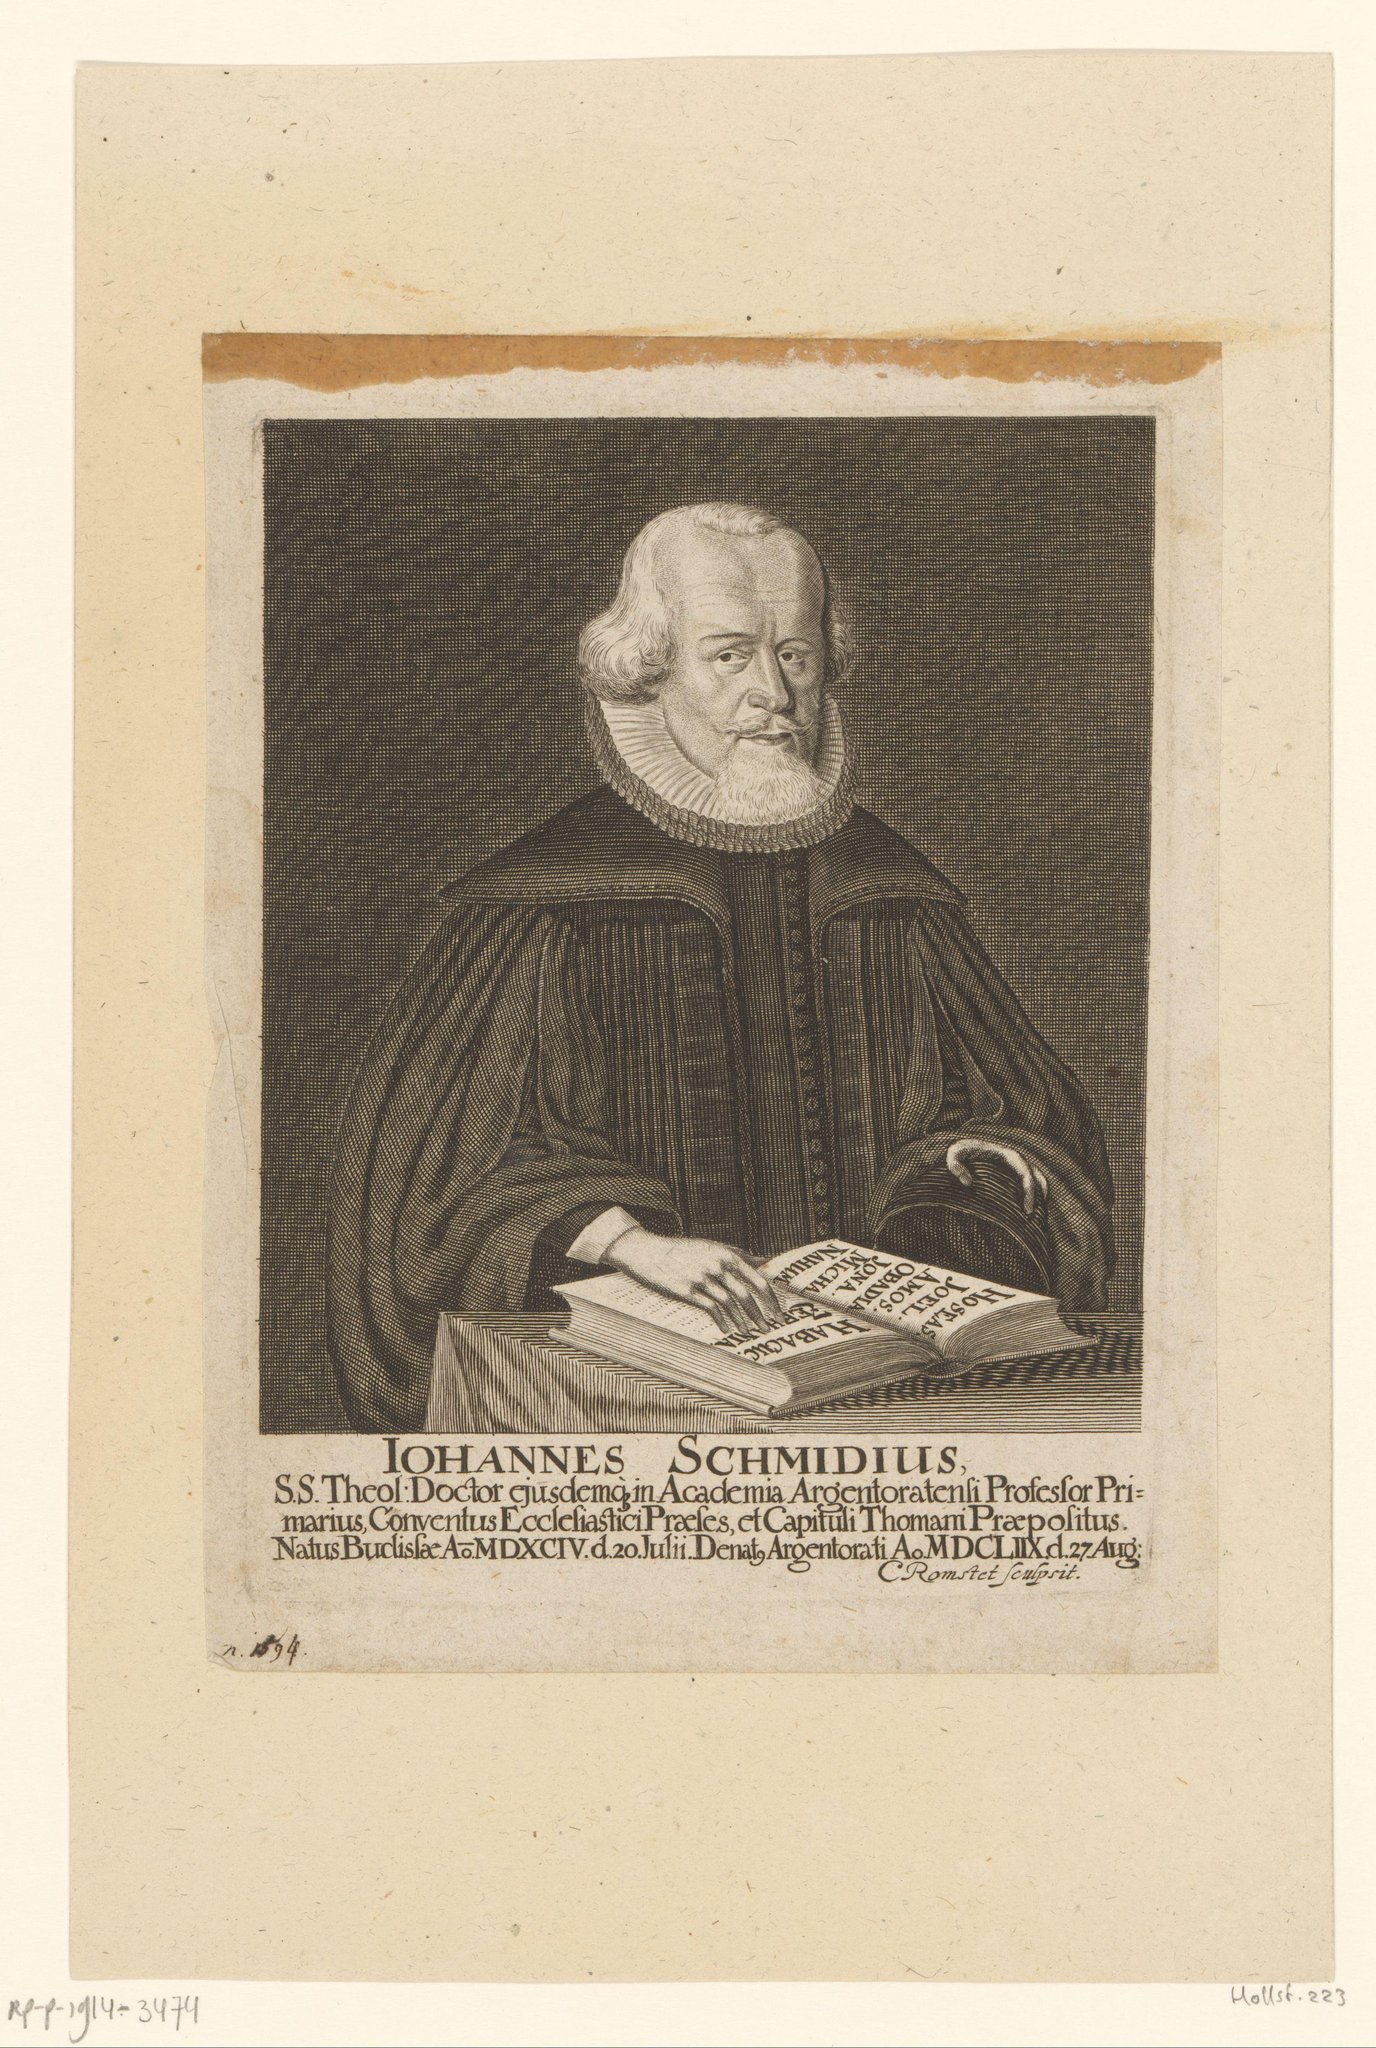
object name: print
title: Portret van Johann Schmidt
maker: christian romstet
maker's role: print maker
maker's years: 1640-1721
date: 1665-1721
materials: paper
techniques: engraving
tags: johann schmidt, historical persons, book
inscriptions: collector's mark: Lugt 2228